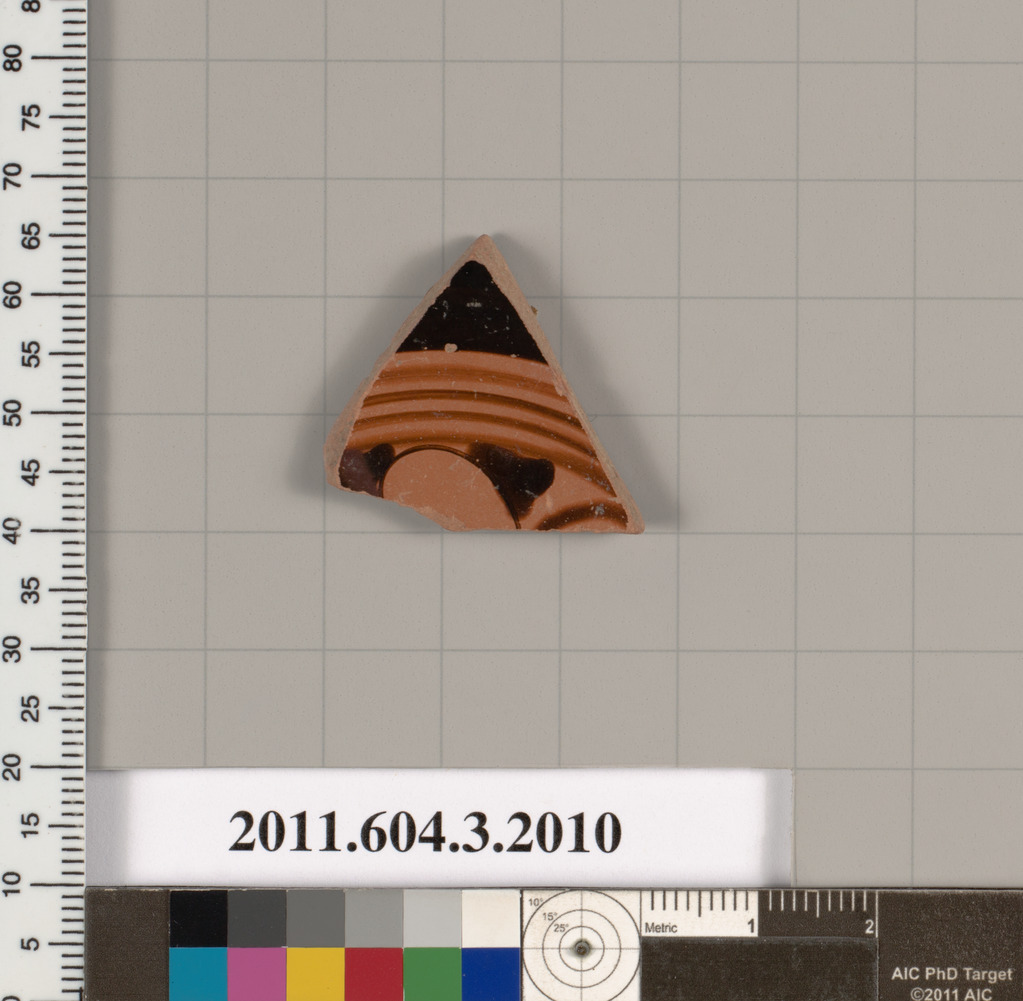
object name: kylix fragment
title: Terracotta fragment of a kylix (drinking cup)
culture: greek, attic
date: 550-526 BCE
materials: terracotta